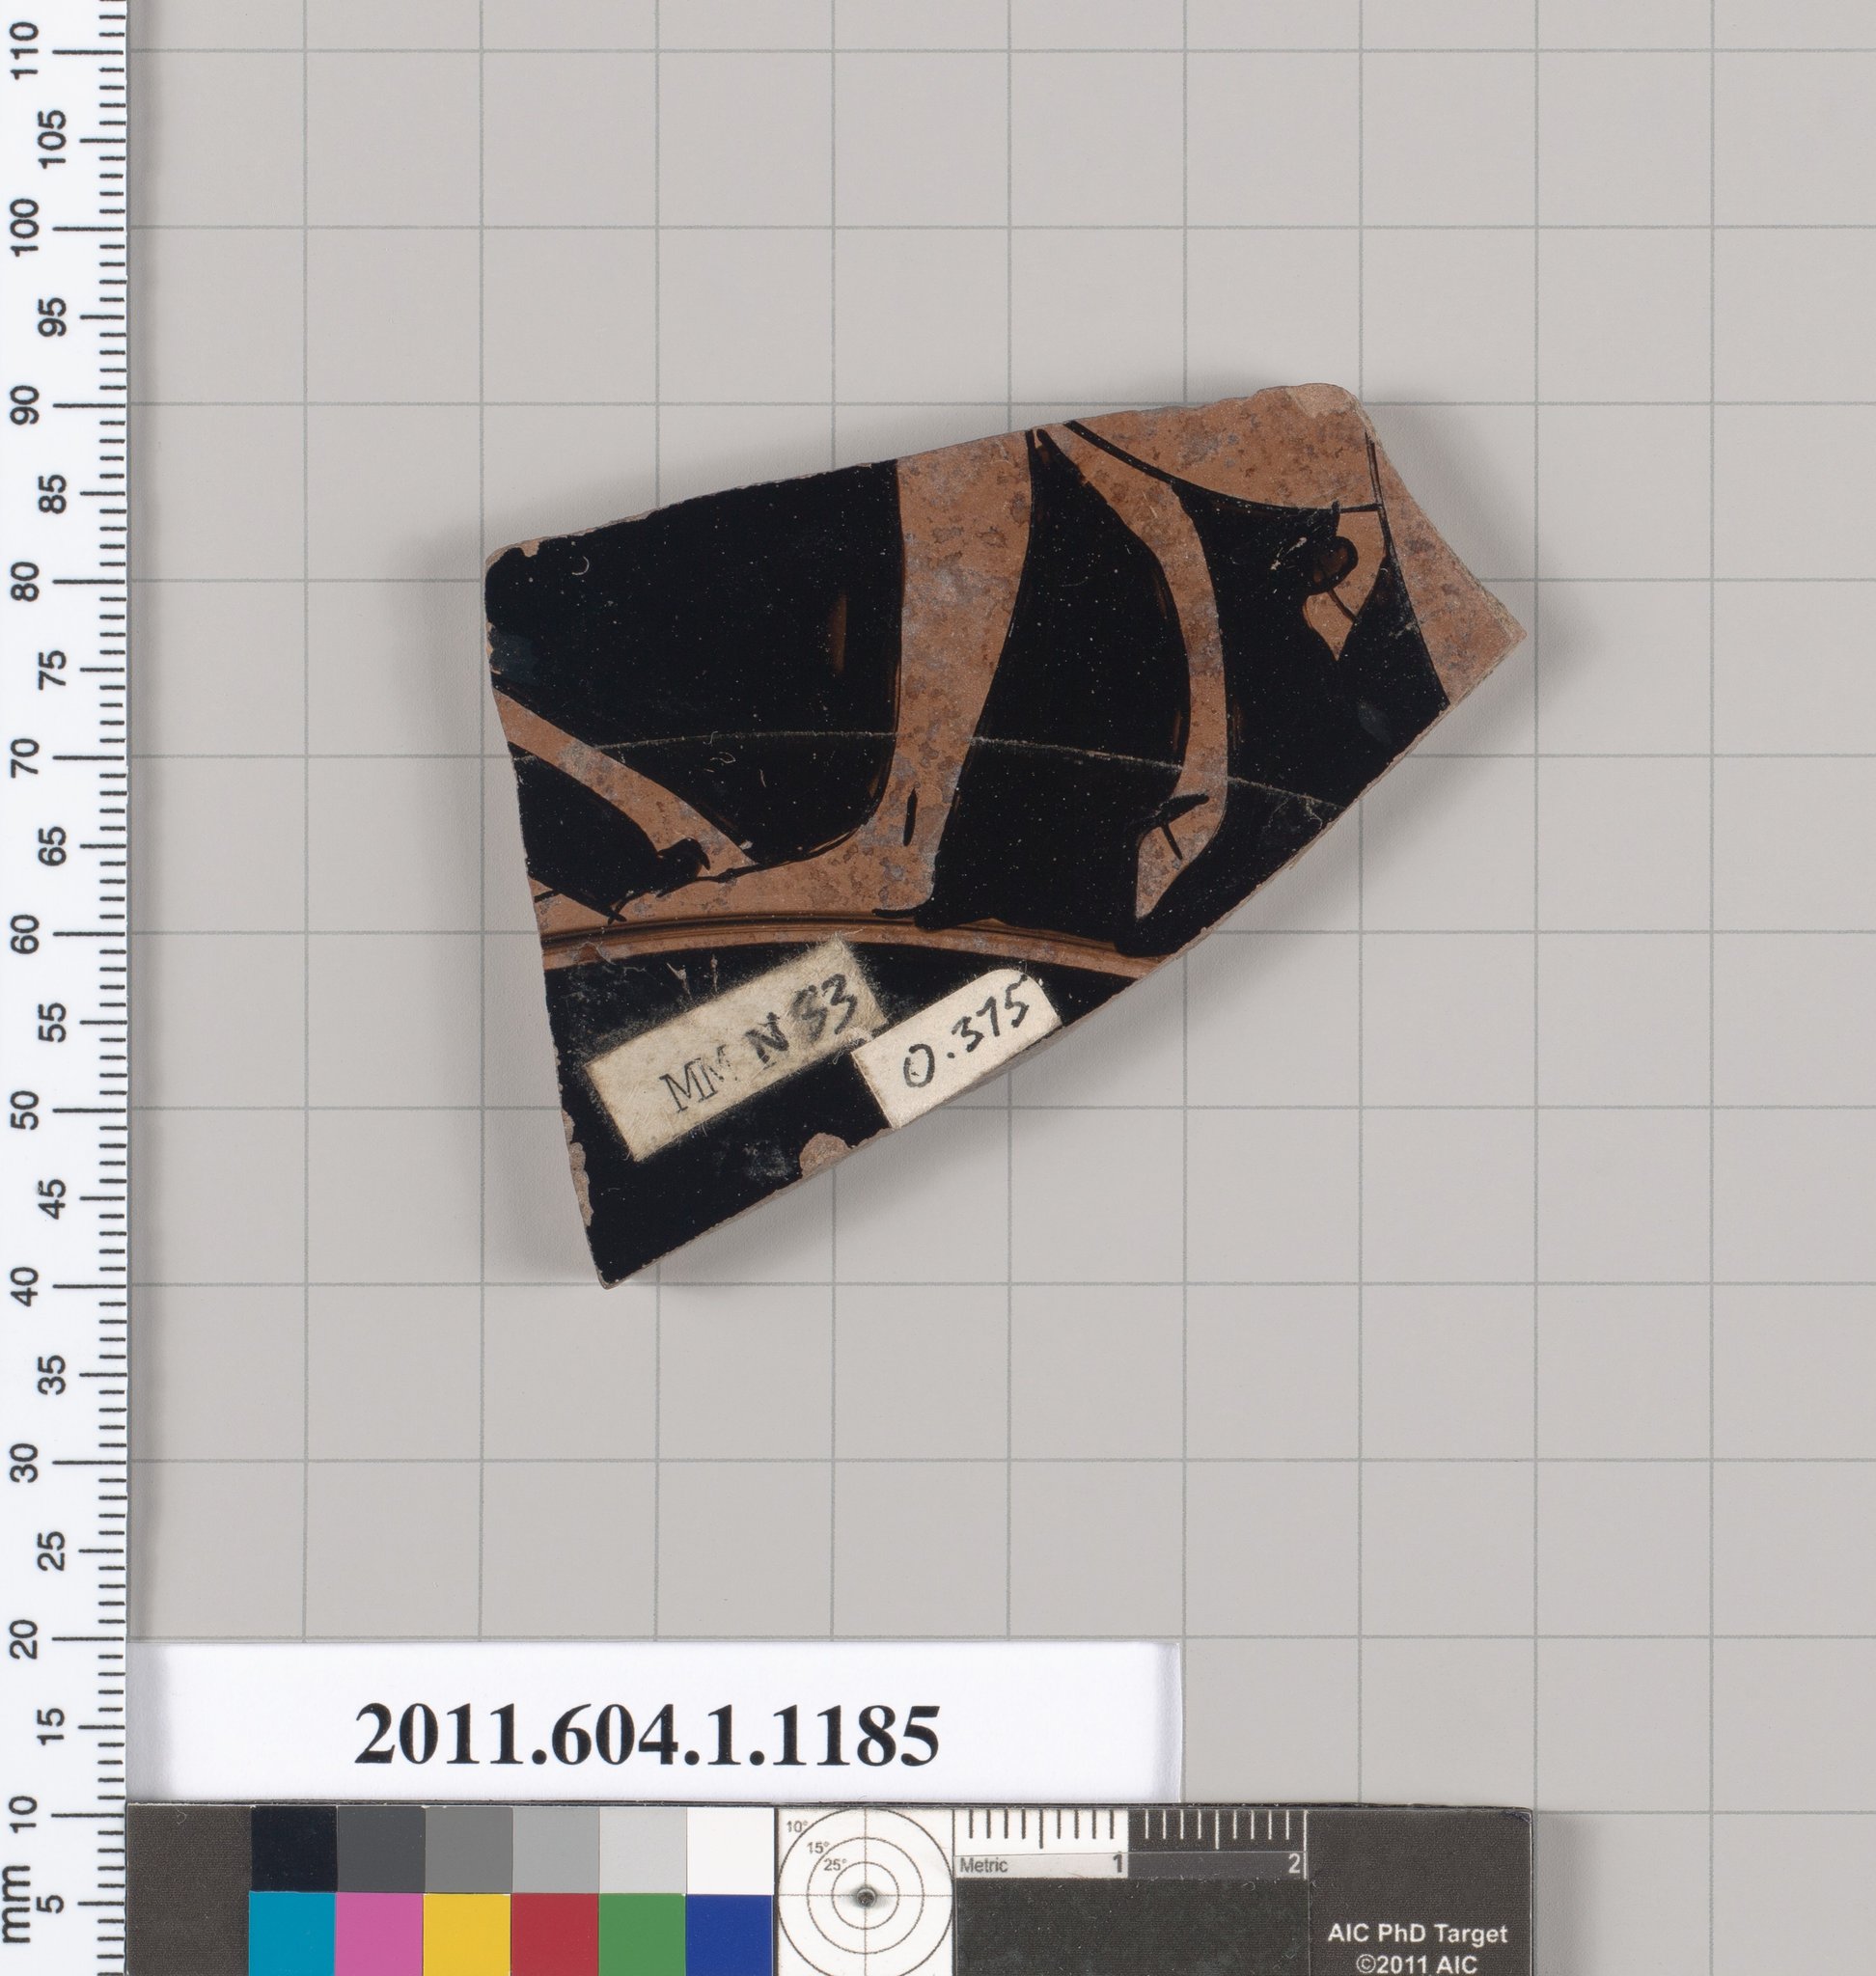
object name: kylix fragment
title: Terracotta fragment of a kylix? (drinking cup)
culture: greek, attic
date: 534-501 BCE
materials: terracotta